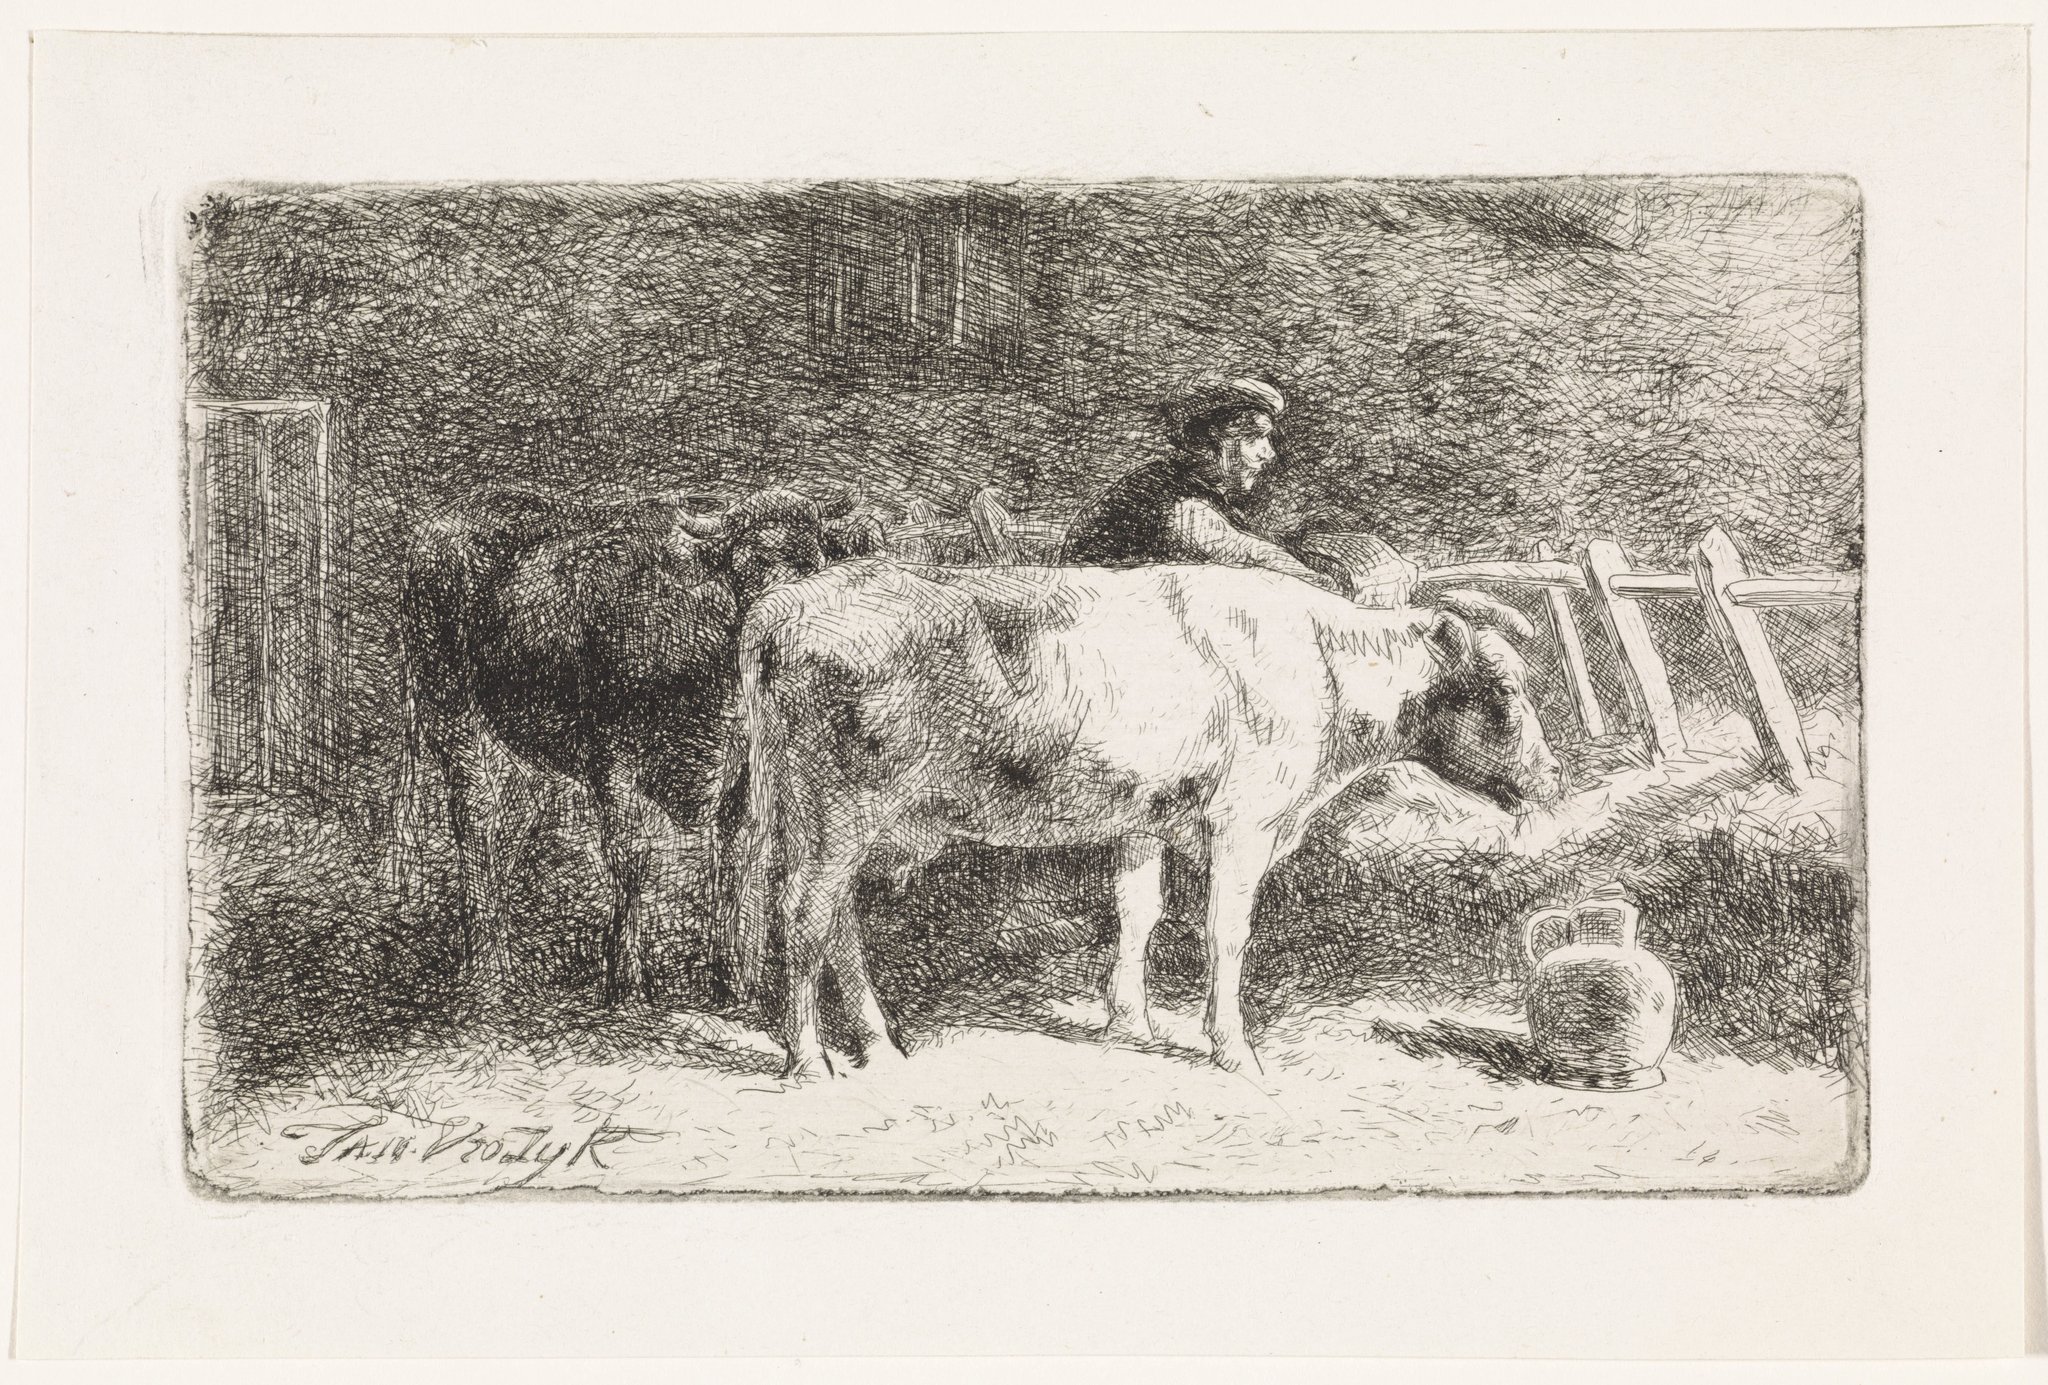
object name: print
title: Boer tussen twee koeien bij een ruif in een stal (grote variant)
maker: jan vrolijk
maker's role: draughtsman, painter, print maker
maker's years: 1846-1894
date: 1860-1894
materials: paper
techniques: etching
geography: the hague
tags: cow, farmers, stall, stable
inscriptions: collector's mark: Lugt 2228